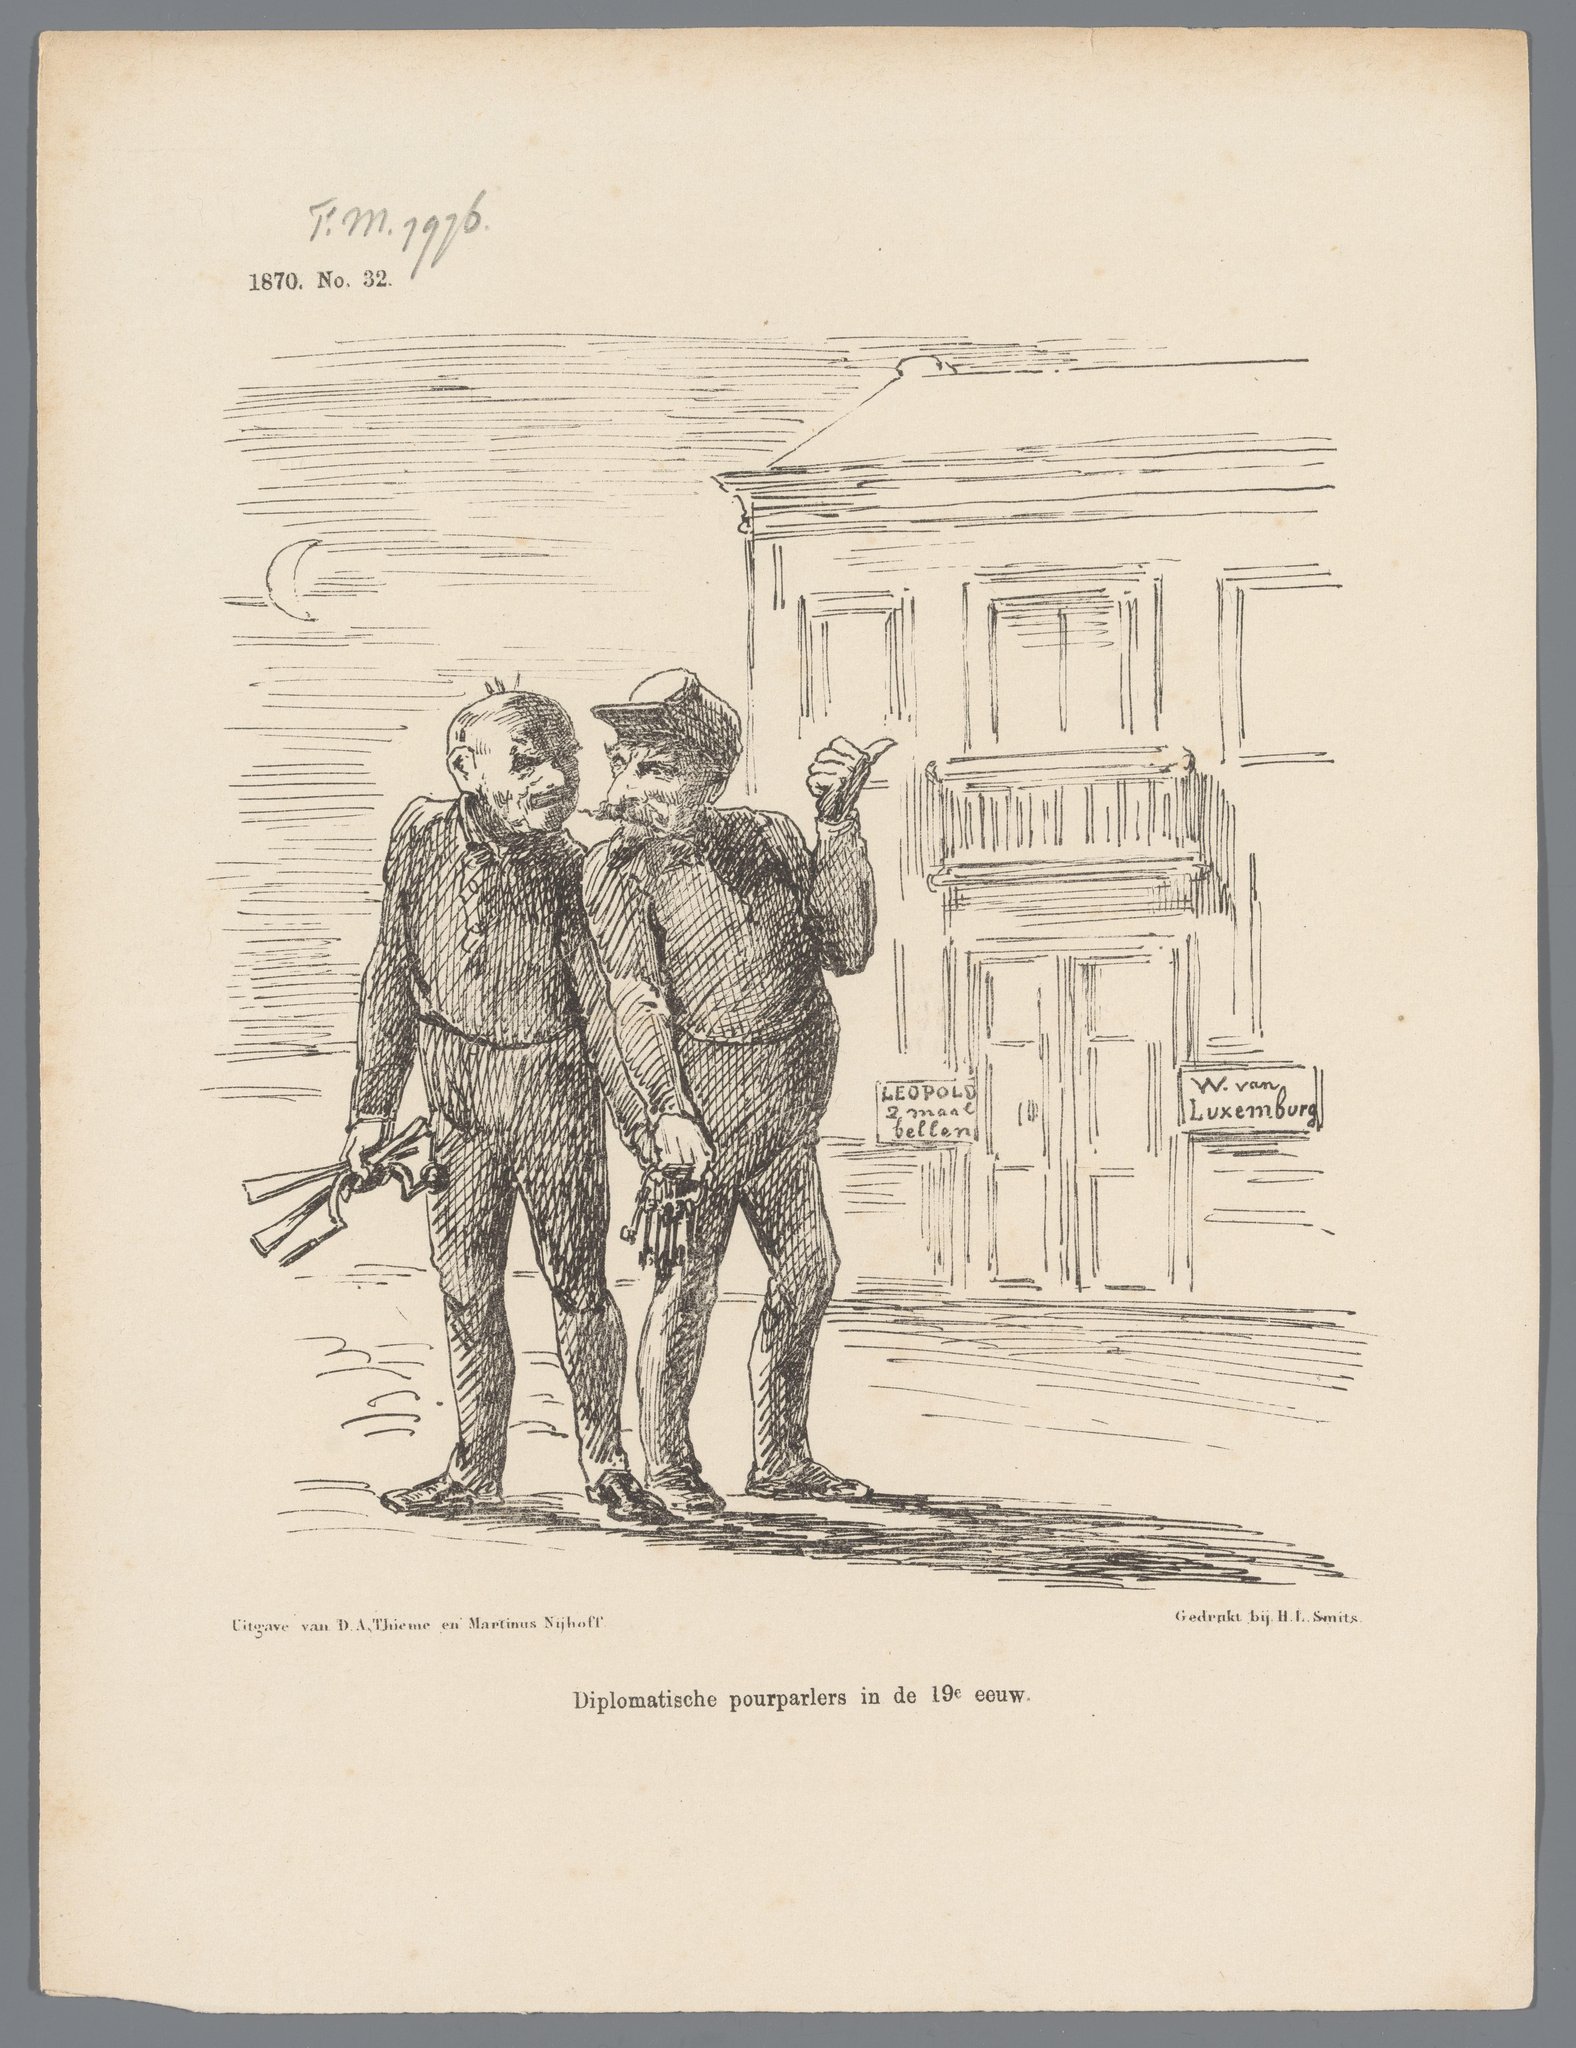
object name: print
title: Diplomatische pourparlers in de 19e eeuw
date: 1870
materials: paper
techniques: lithograph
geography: the hague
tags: brussels, laeken, leopold ii (koning der belgen), paris, london, napoleon iii (keizer der fransen), willem iii (koning der nederlanden), burglar, housebreaker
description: Spotprent nav de geruchten van annexatie van België en Luxemburg door Frankrijk en Duitsland. Twee inbrekers (Otto von Bismarck en keizer Napoleon III) loeren naar het paleis van koning Leopold van België en koning Willem III (van Luxemburg). Plaat verschenen bij het weekblad De Nederlandsche Spectator, nr. 32, 1870.